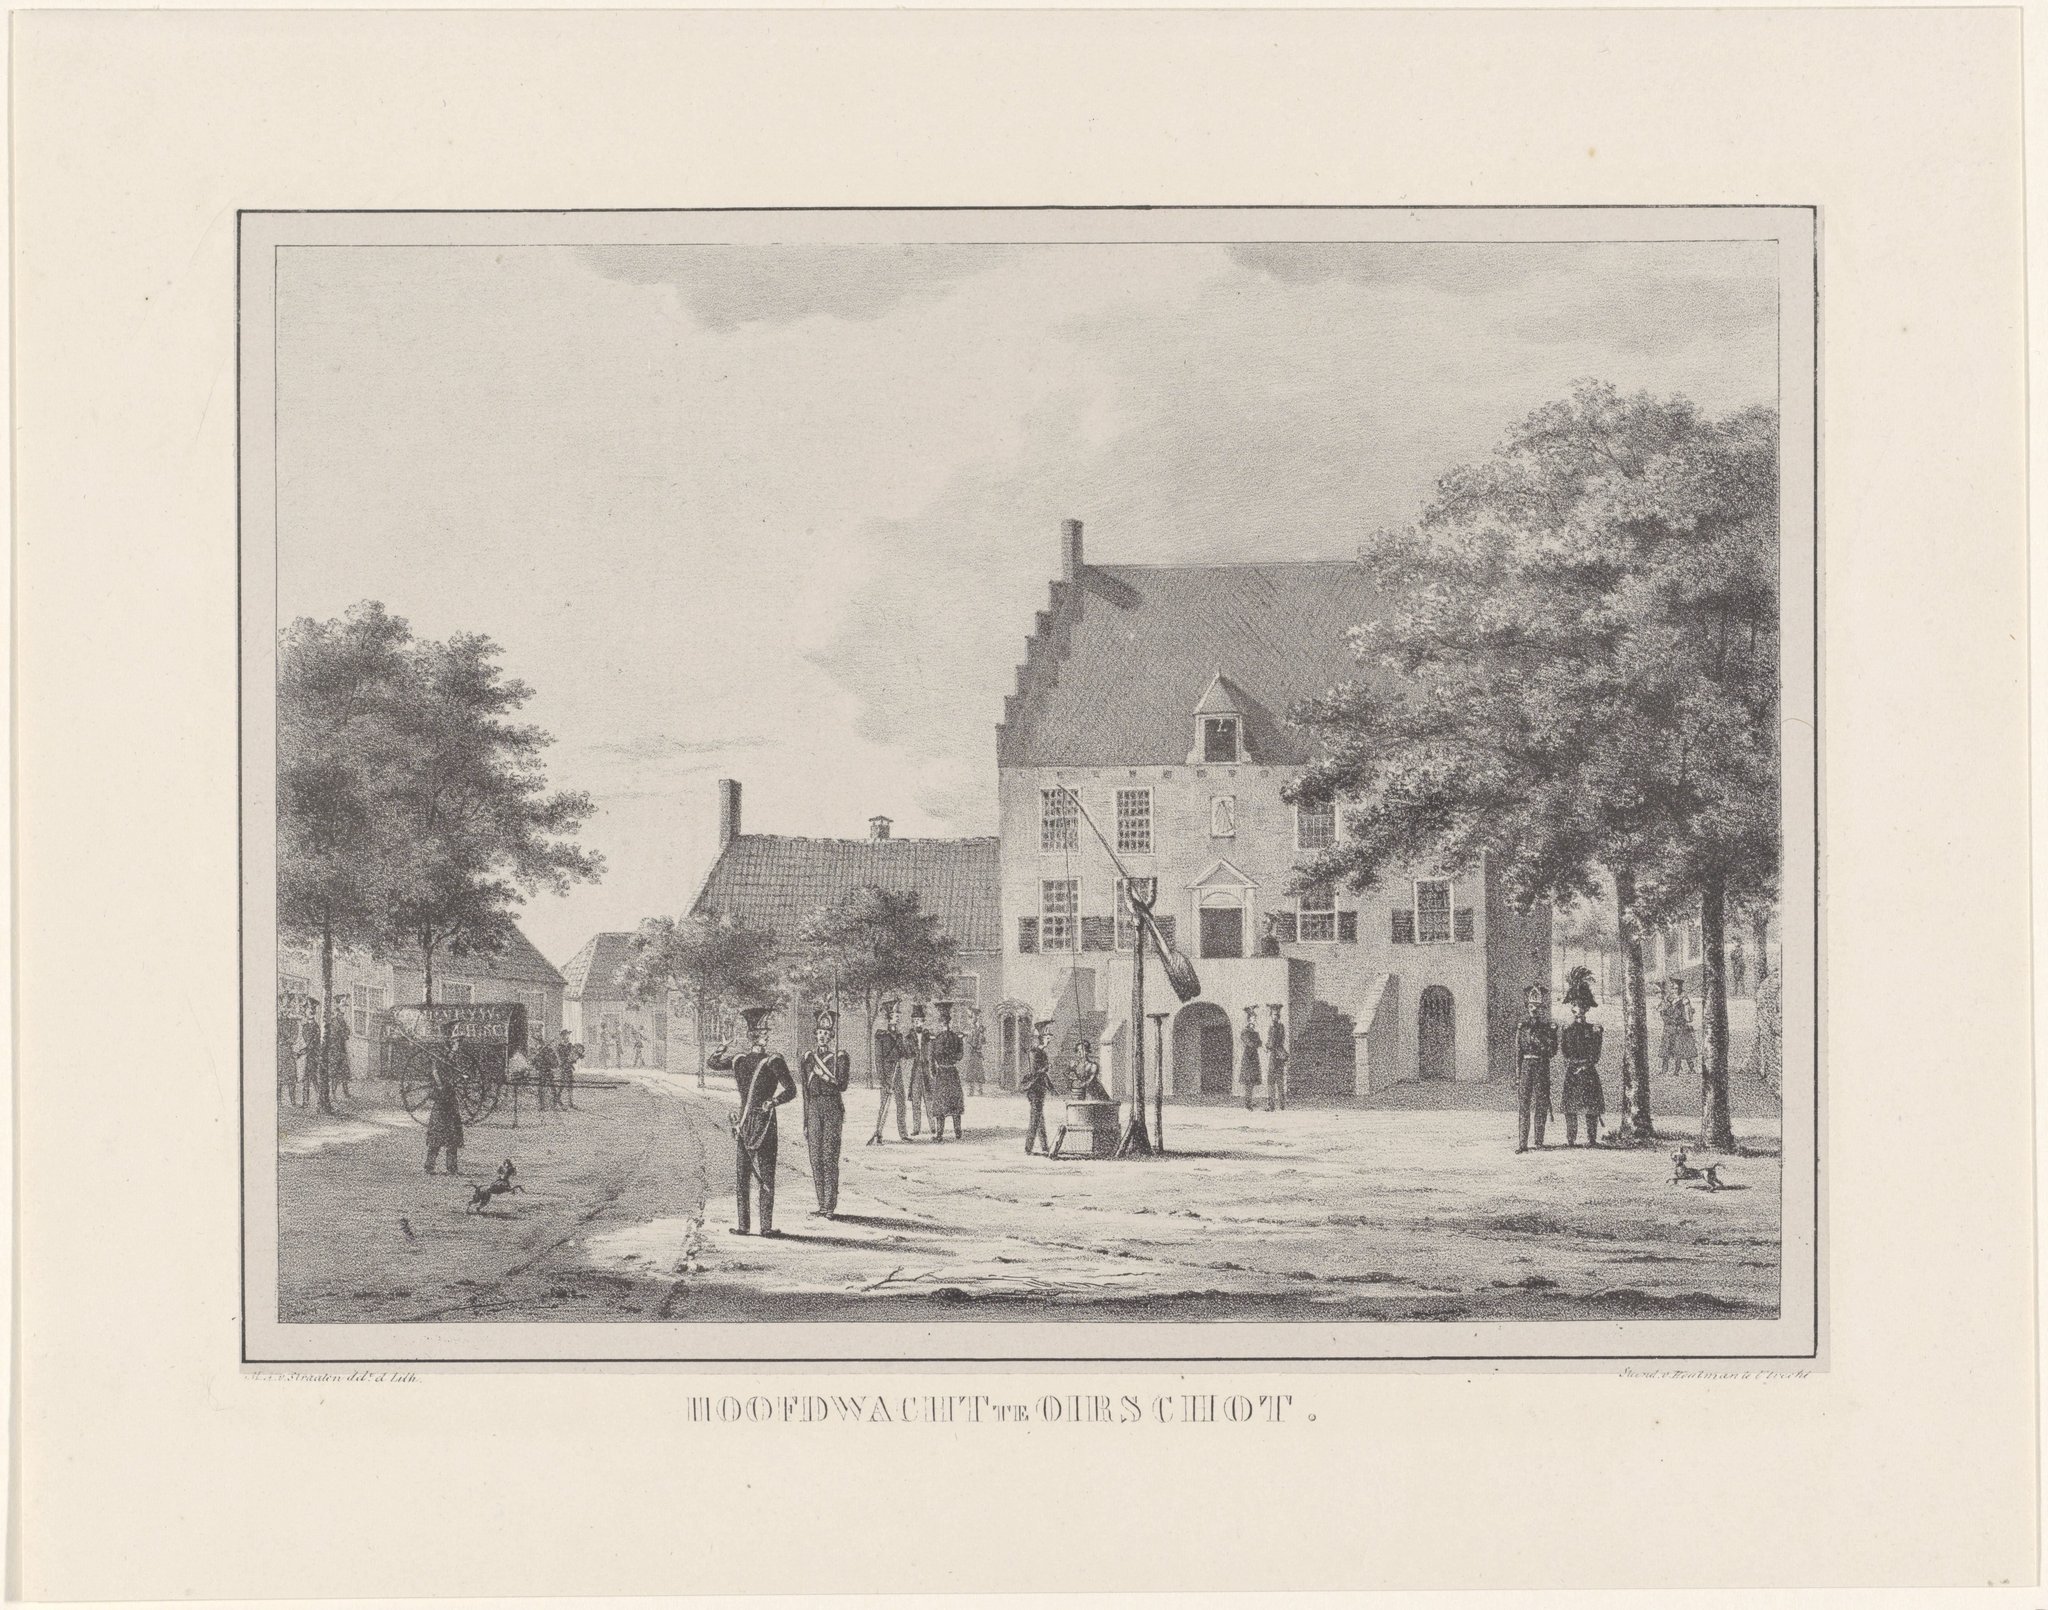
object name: print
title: Hoofdwacht te Oirschot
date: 1830-1831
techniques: printmaking, lithograph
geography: utrecht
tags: shelter ~ military service, guard duty, keeping sentry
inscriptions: collector's mark: Lugt 2228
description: Gezicht te Oirschot met de wachtlokaal van de vrijwillige schutterij. Links een fouragewagen waarop de naam van een Hogeschool. Onderdeel van een serie van vier voorstellingen van de hoofdwachten van de Nederlandse schutterij in Noord-Brabant in 1830-1831.